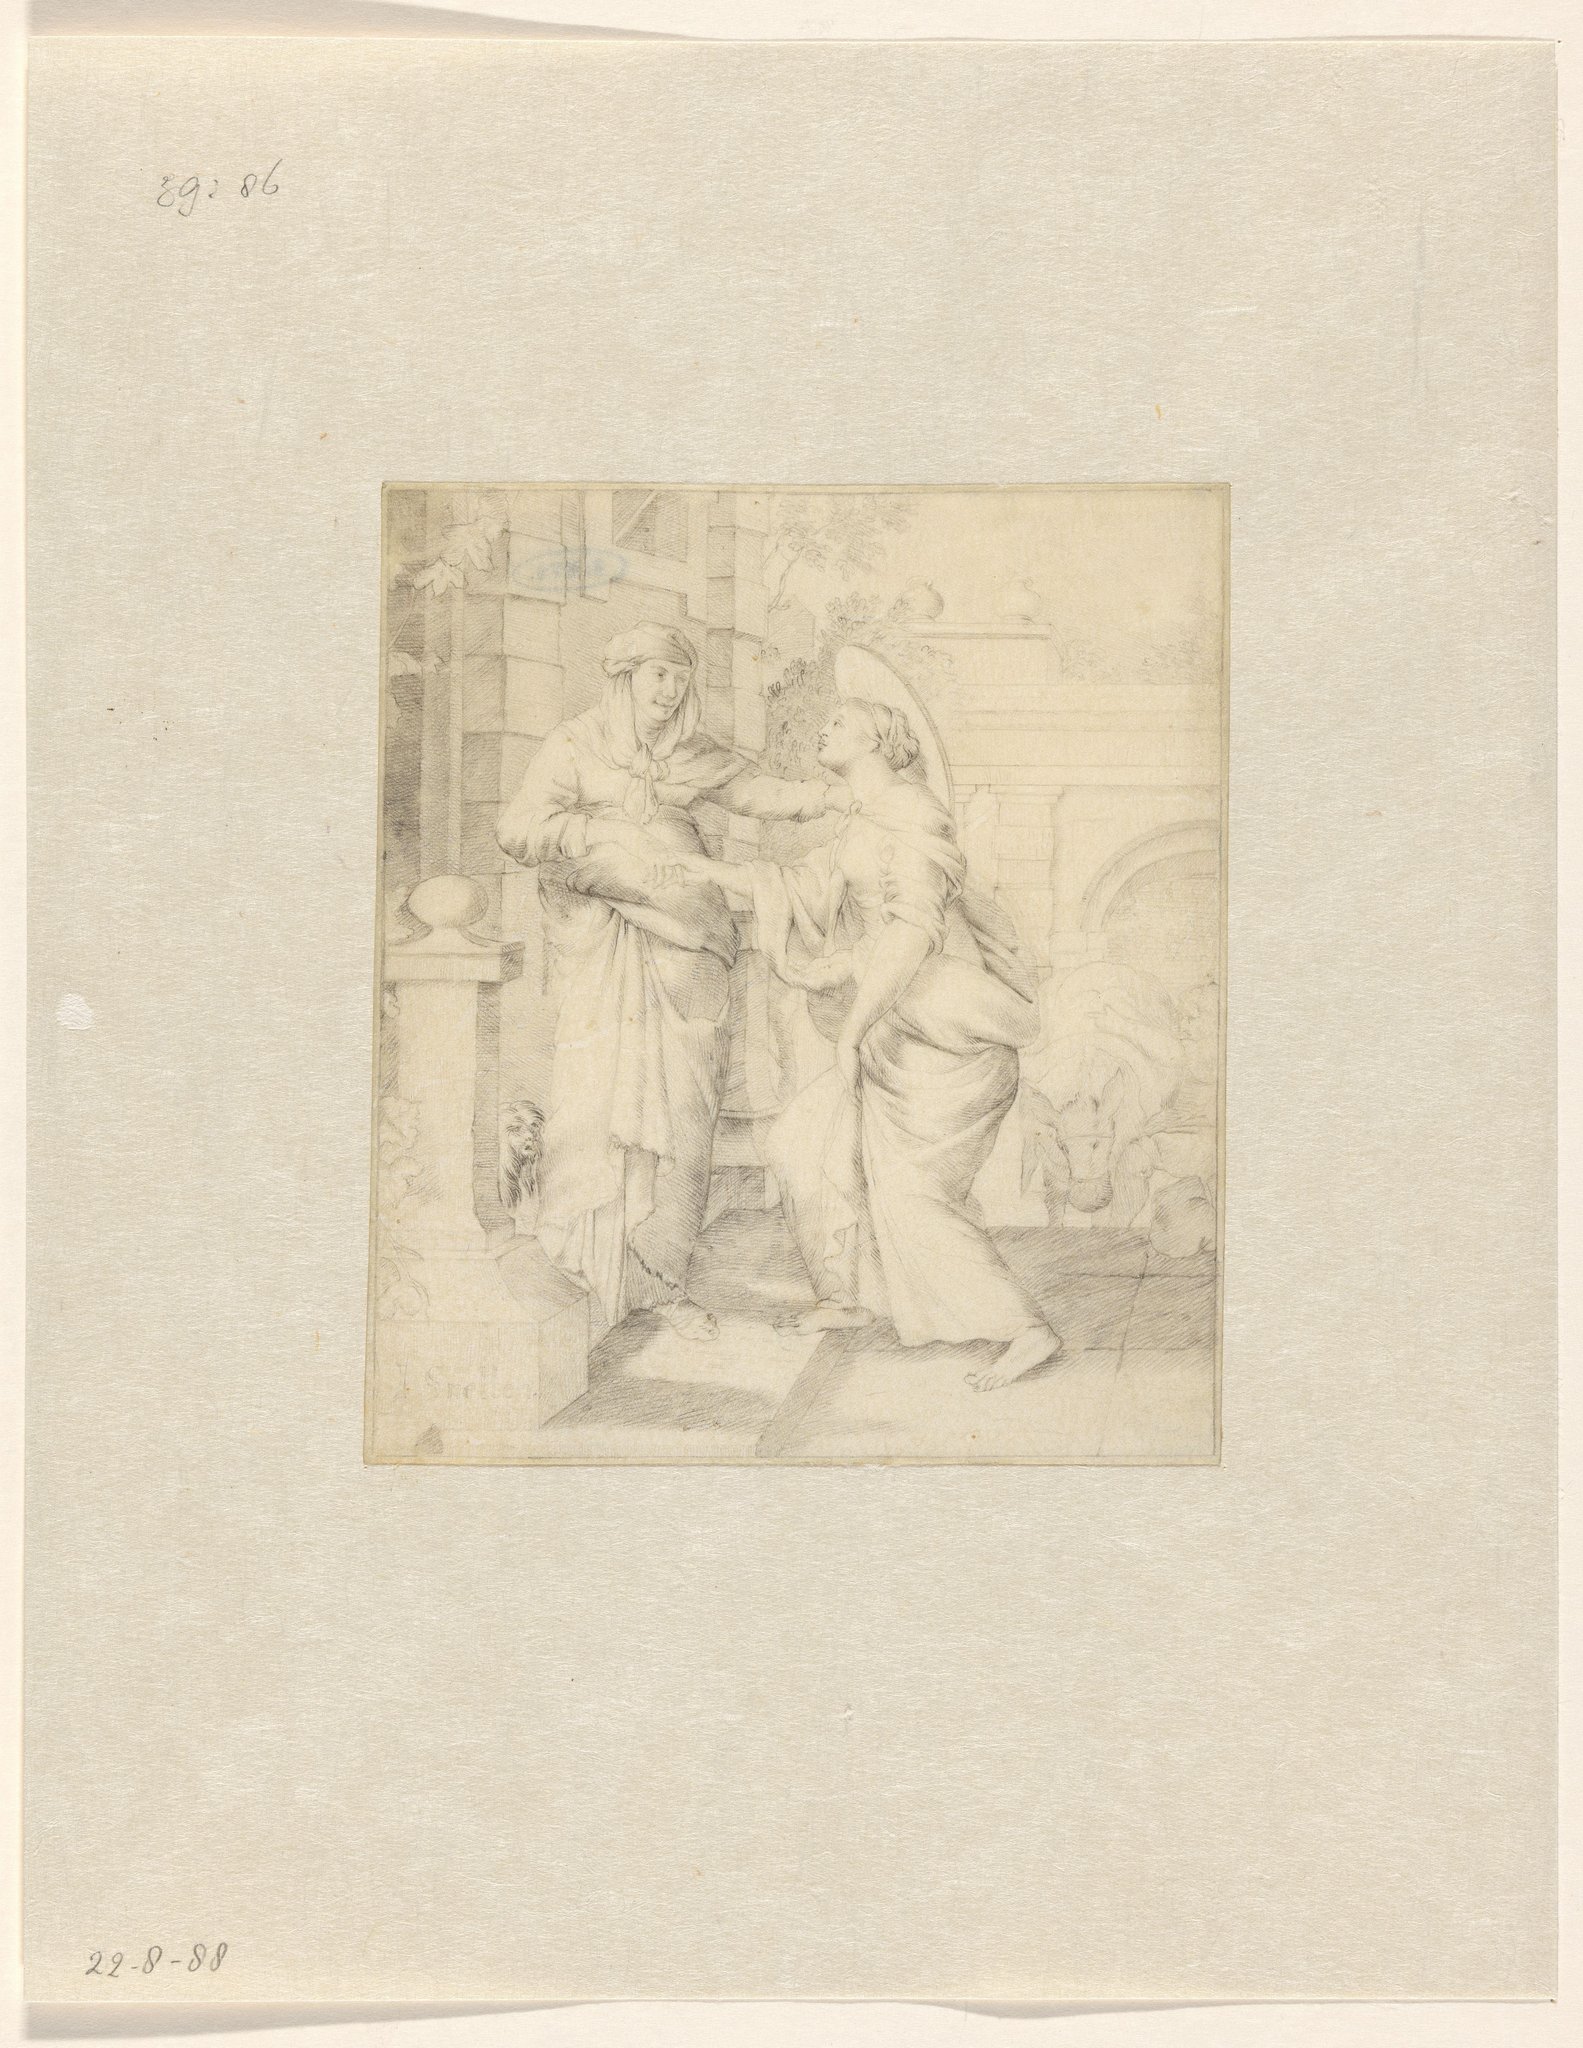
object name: drawing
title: De Visitatie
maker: jan snellen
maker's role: draughtsman, print maker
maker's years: 1711-1787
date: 1721-1787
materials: parchment, pencil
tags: mary and elisabeth shaking hands